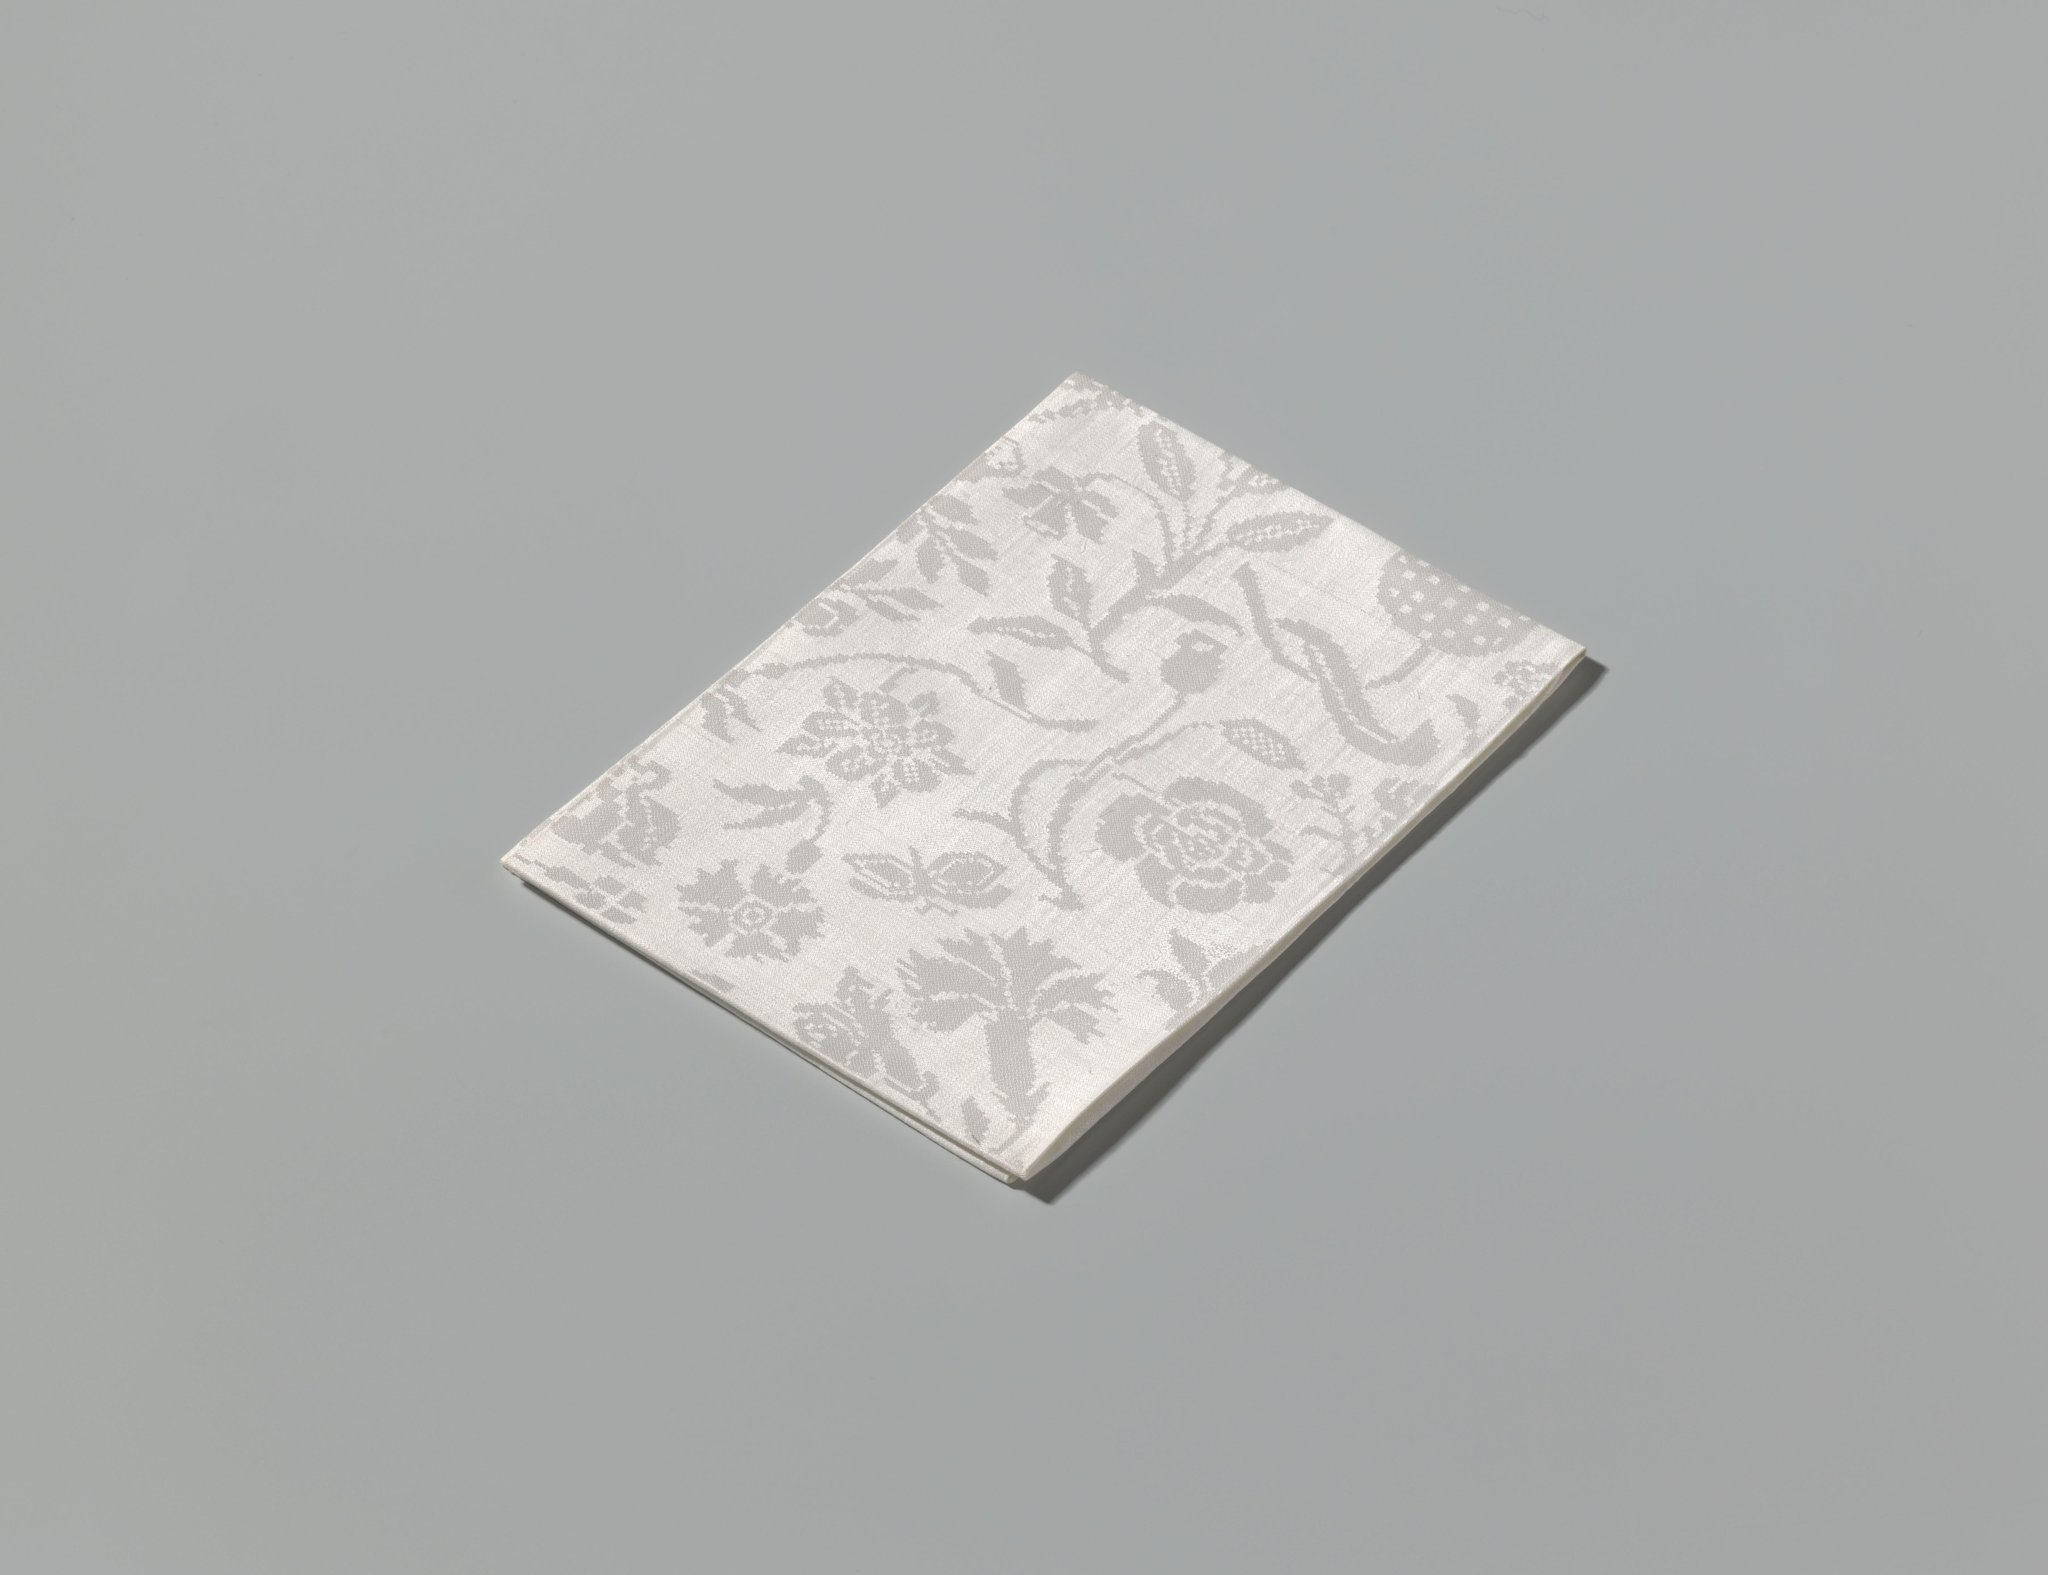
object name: napkin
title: Servet van wit linnendamast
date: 1640-1650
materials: linen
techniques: damask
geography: northern netherlands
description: Wit linnendamasten servet met patroon van gestrooide bloemen en insecten, merk kroon IB 24.